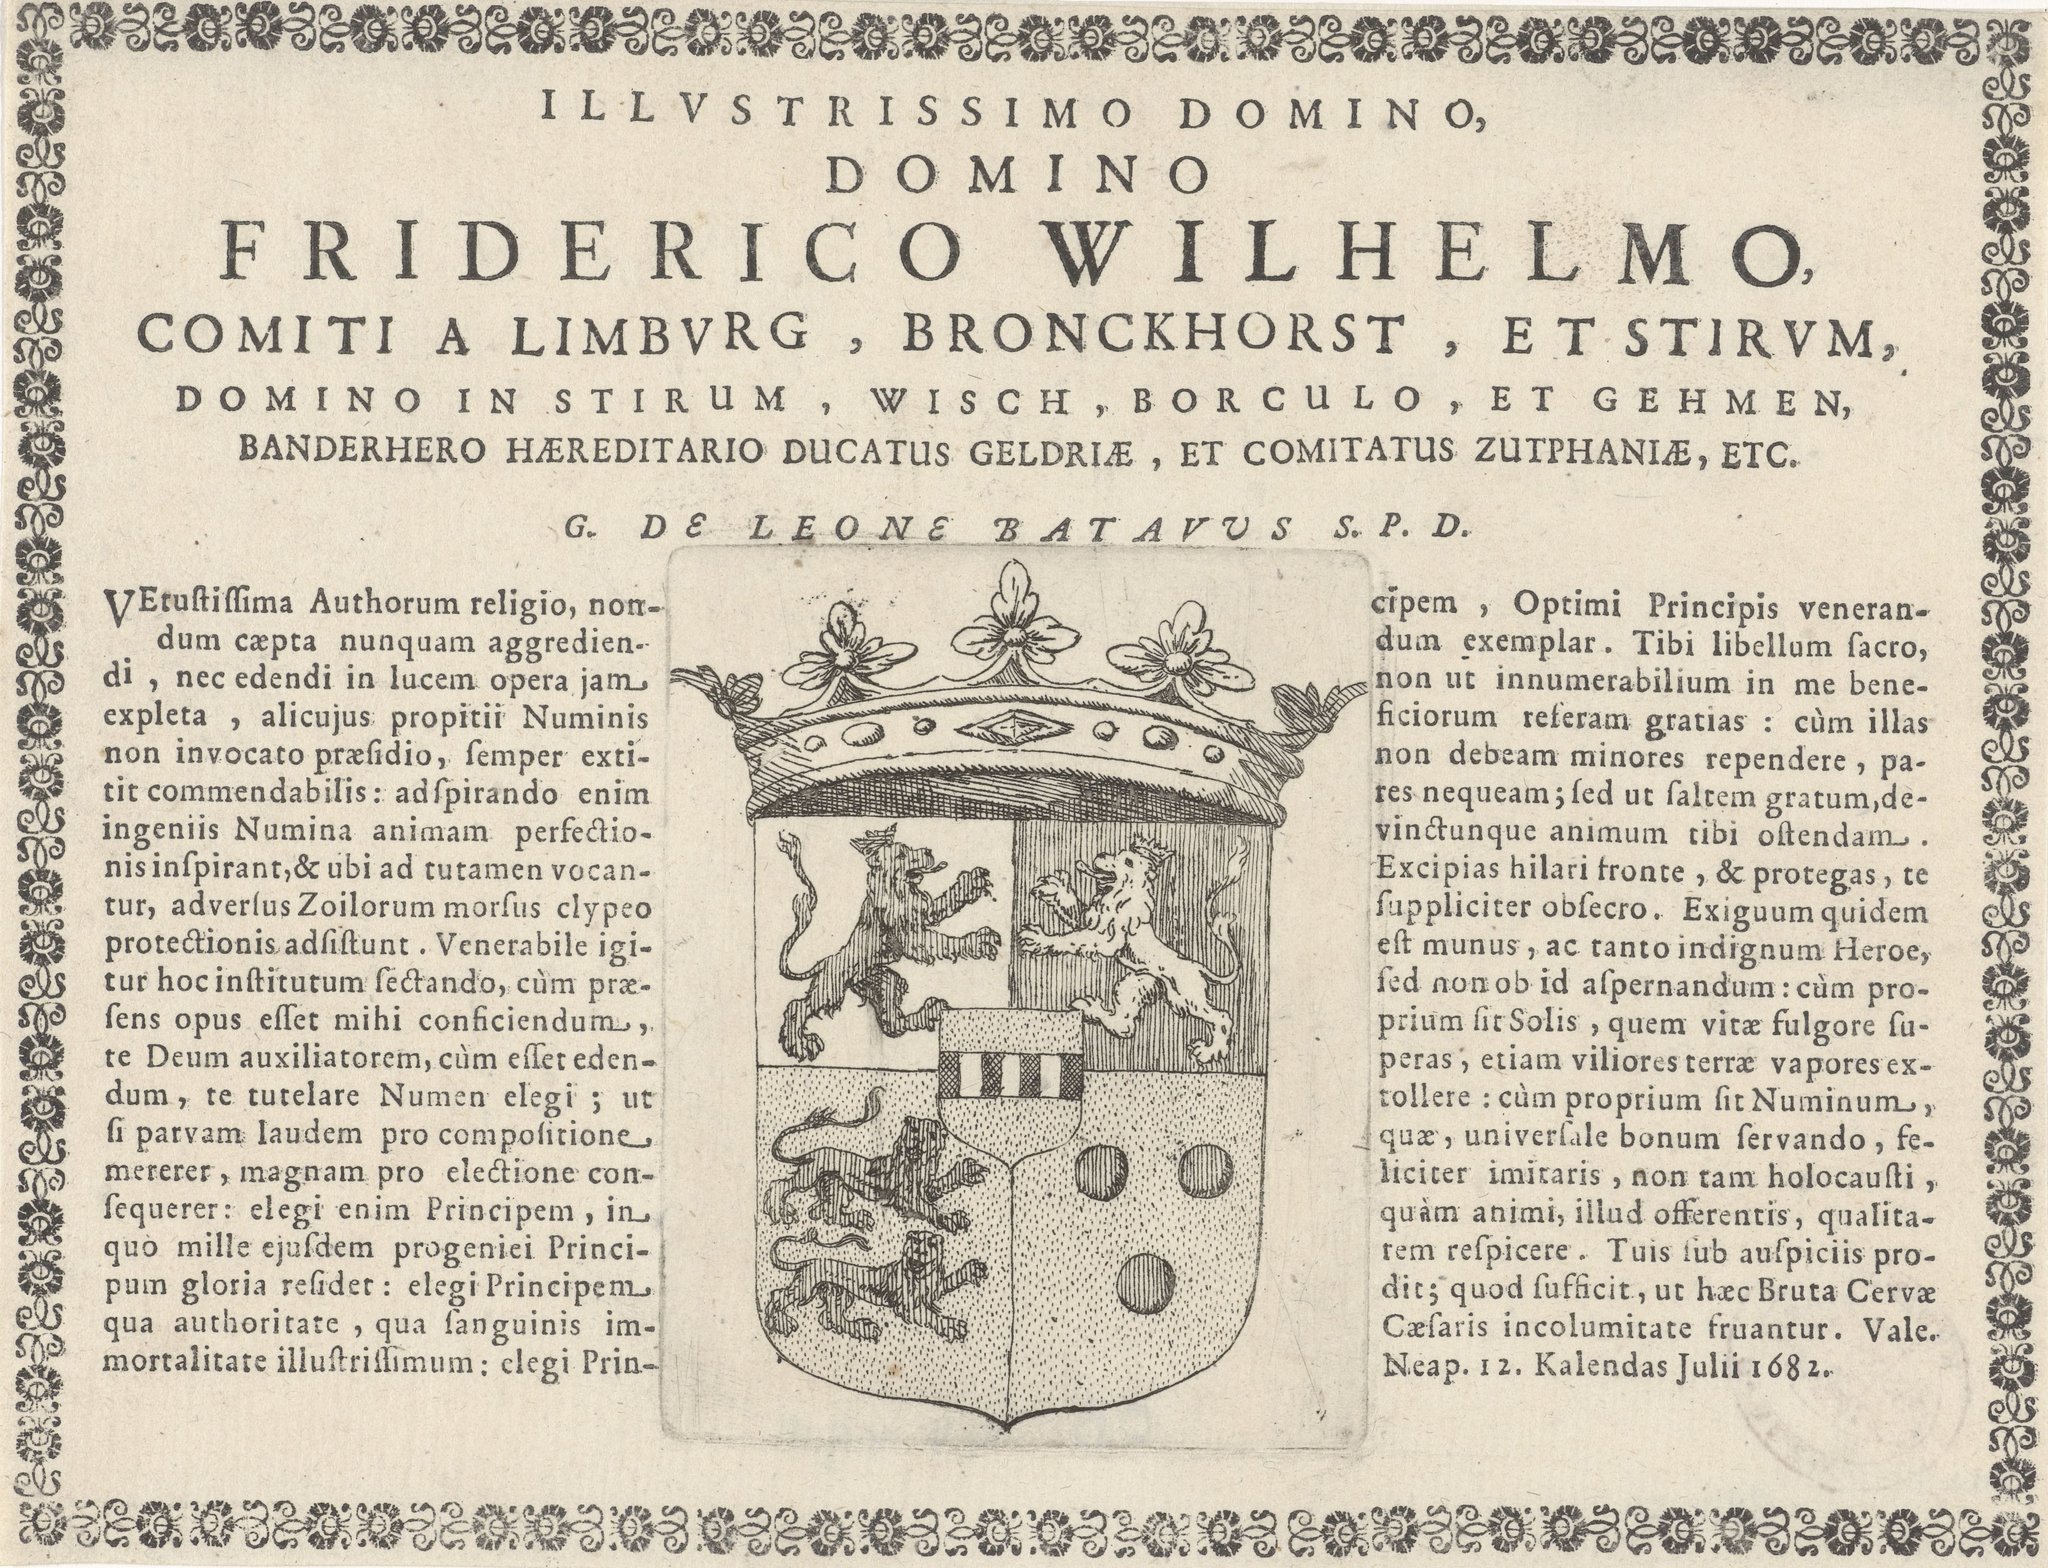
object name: print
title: Friderico Wilhelmo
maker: govert van der leeuw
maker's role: print maker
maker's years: 1645-1688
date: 1682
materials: paper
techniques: etching, letterpress printing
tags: armorial bearing, heraldry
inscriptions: collector's mark: Lugt 240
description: Gekroond wapenschild van Frederik Willem, graaf van Limburg en Bronckhorst. Aan weerszijden twee kolommen tekst.